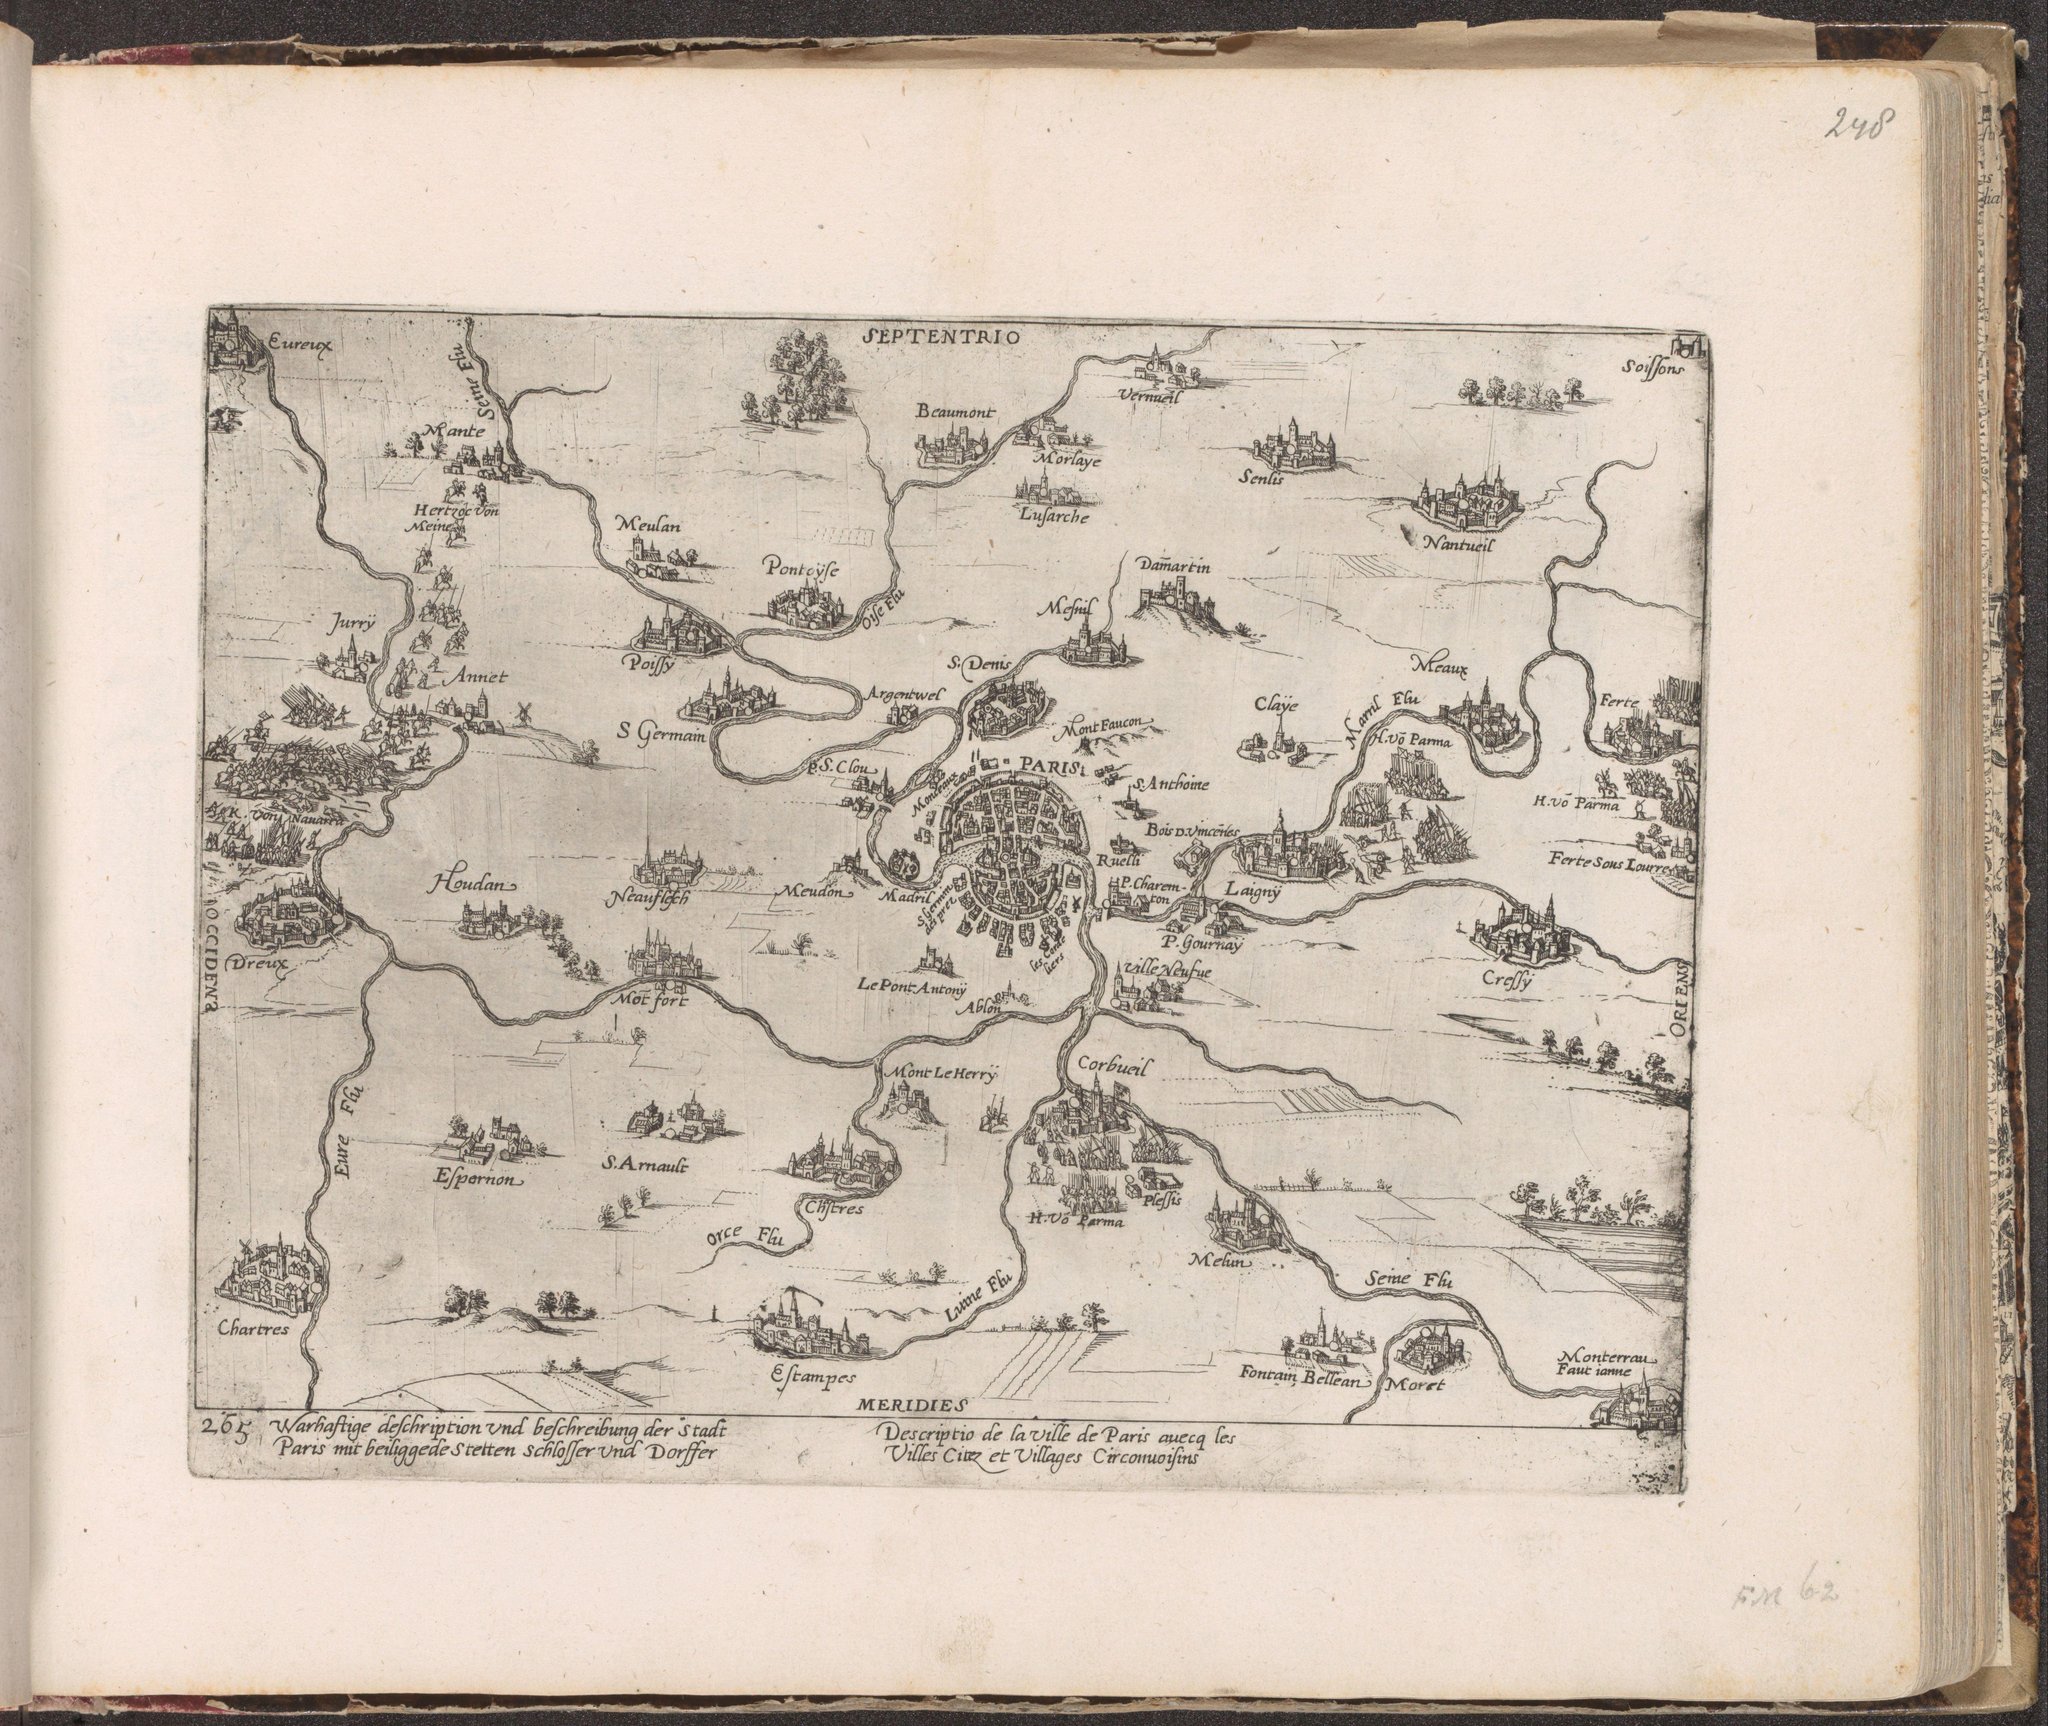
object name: print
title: Kaart van Parijs en omgeving, 1590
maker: frans hogenberg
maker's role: print maker, publisher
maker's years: 1538-1590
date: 1590-1612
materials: paper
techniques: etching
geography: cologne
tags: rome, alessandro farnese (landvoogd van de nederlanden en hertog van parma en piacenza), paris, hendrik iv (koning van frankrijk en navarra), maps of separate countries or regions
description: Kaart van Parijs en omgeving met de ligging van de troepen van Hendrik IV en de hertog van Parma, 1590. Met onderschrift van 2 regels in het Duits en 2 regels in het Frans. Linksonder genummerd: 265. De prent maakt deel uit van een album.